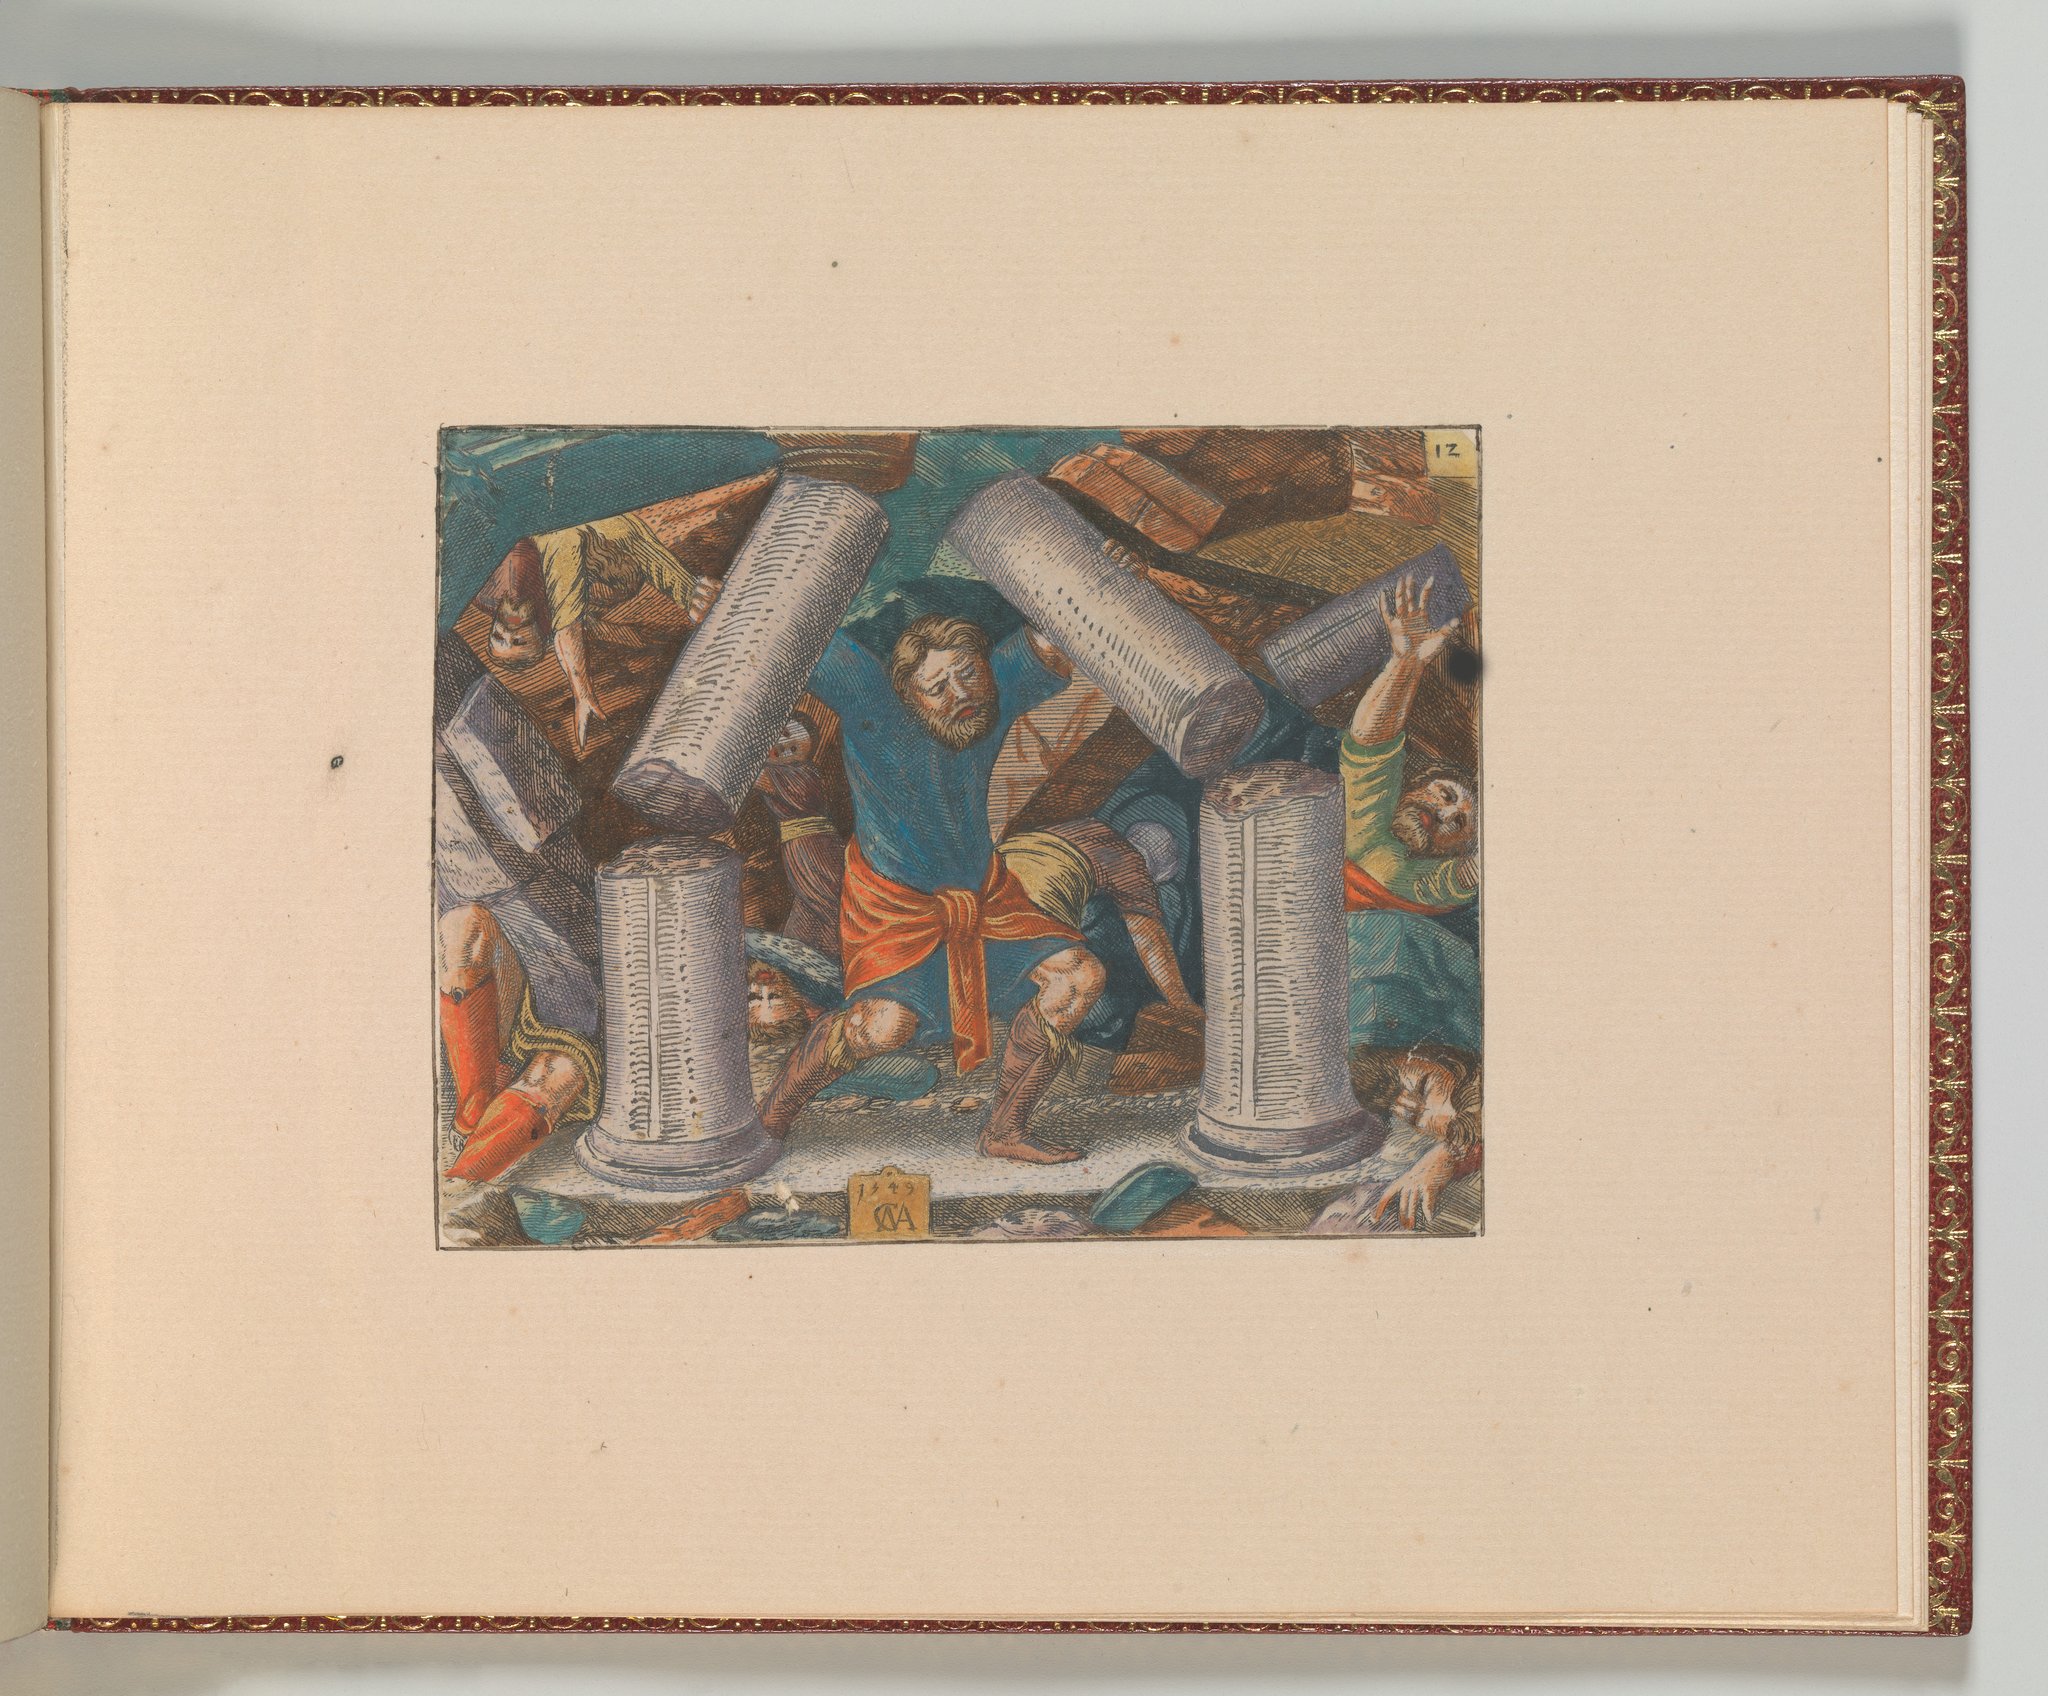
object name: album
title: The Story of Samson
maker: cornelis massys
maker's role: artist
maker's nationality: netherlandish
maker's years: 1510-1557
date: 1549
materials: board, gold, leather, marble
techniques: bookbinding, engraving, hand coloring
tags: columns,men,samson